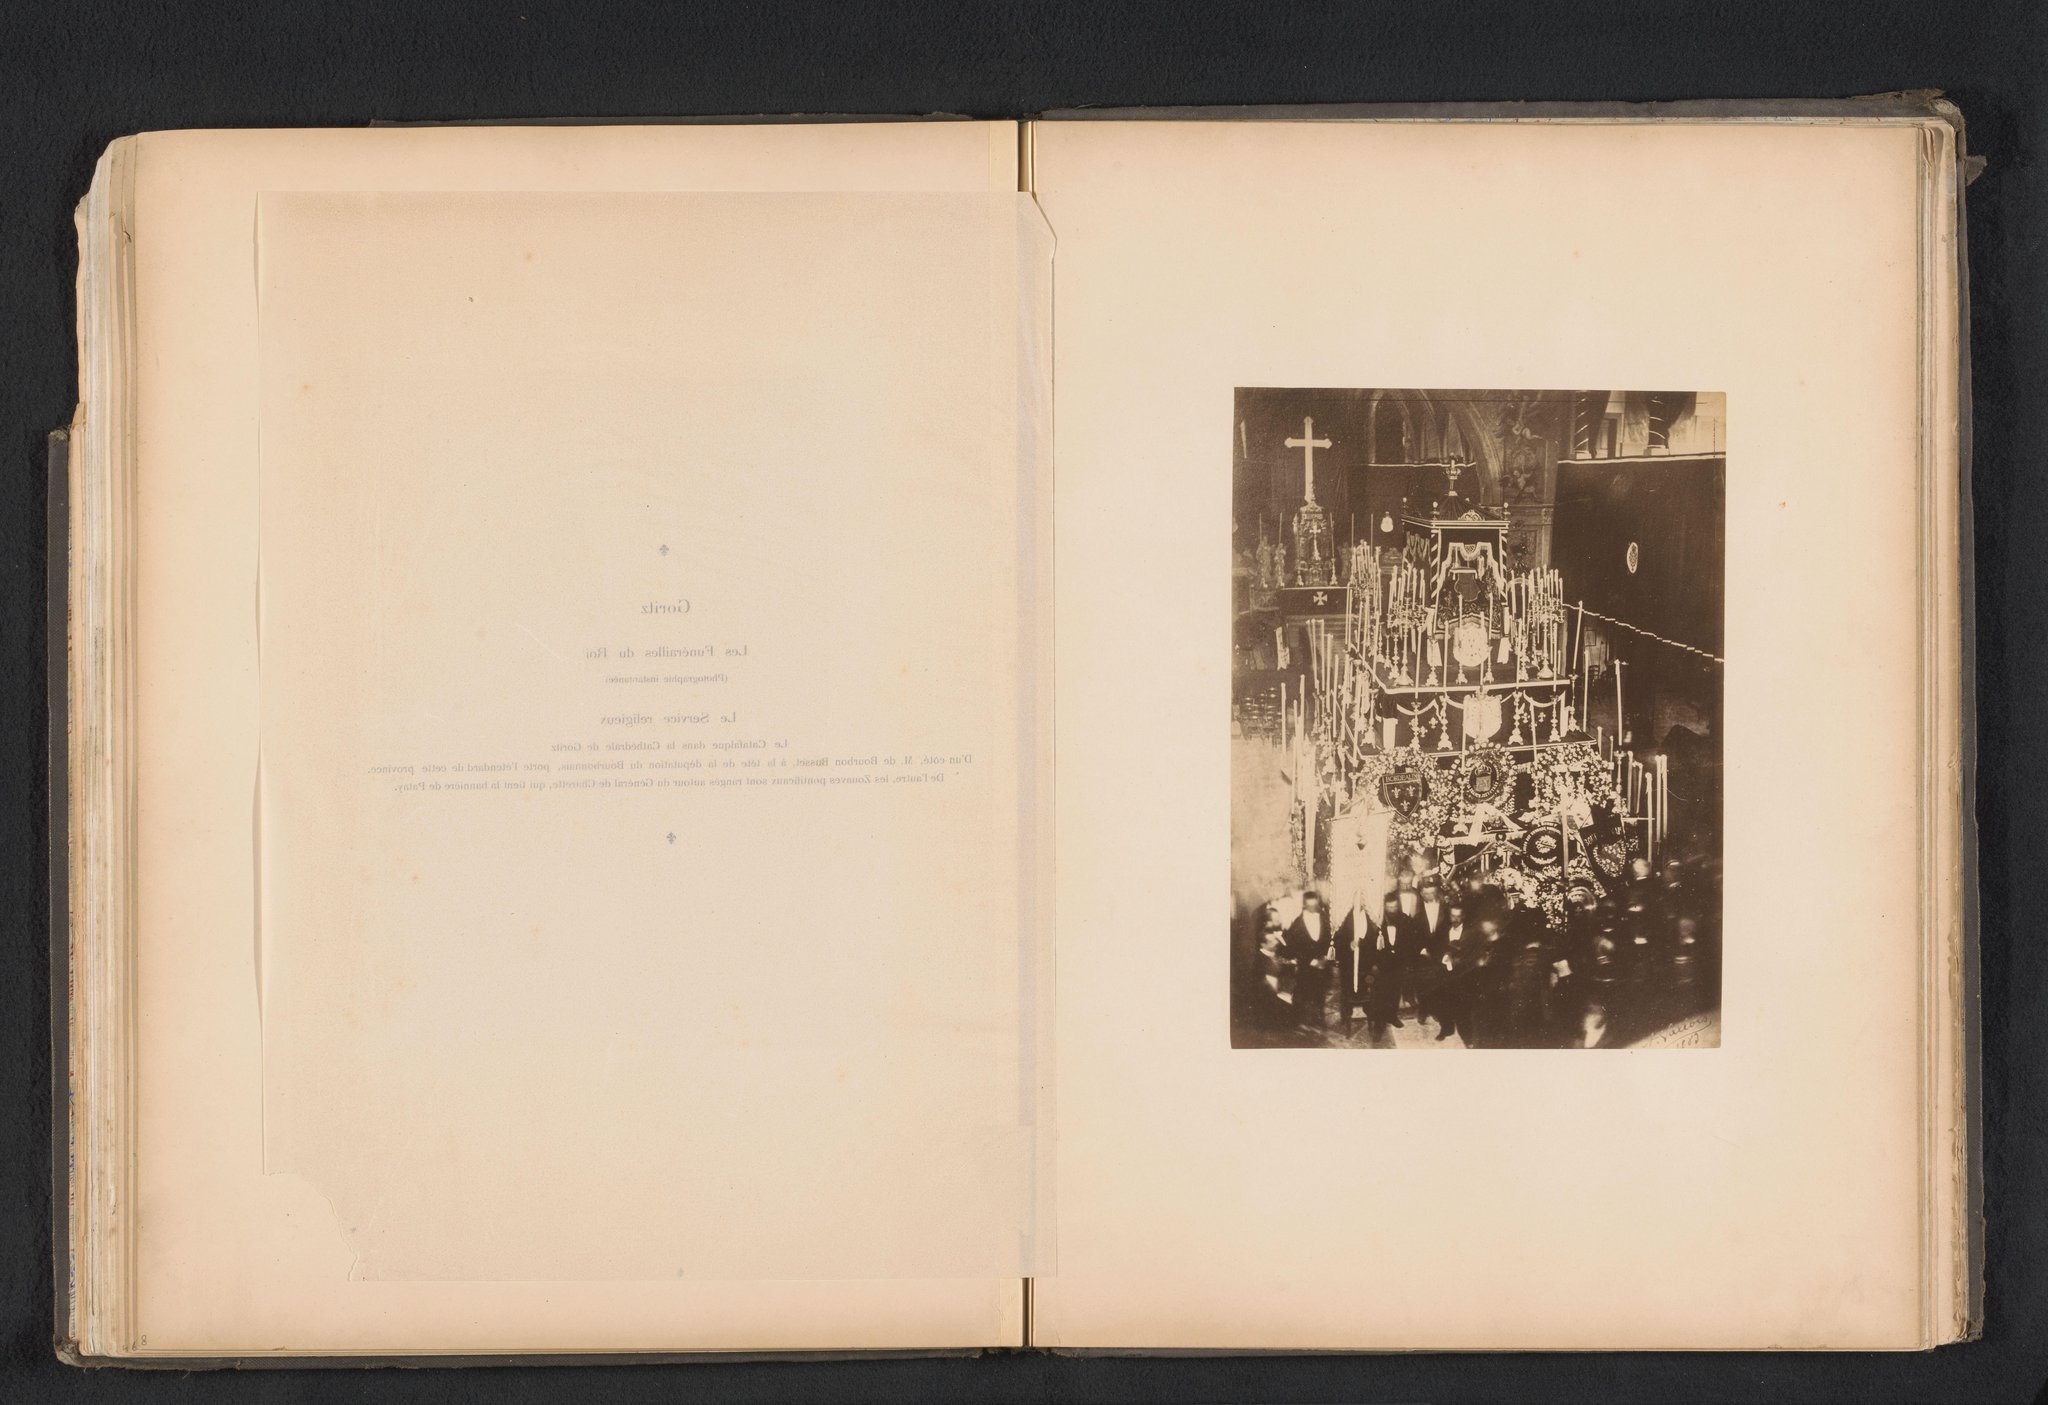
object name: photograph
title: Kerkdienst van de begrafenis van Henri d'Artois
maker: a. vallois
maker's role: fotograaf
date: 1878-1883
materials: photographic support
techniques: albumen print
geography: göritz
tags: funerary ceremonial